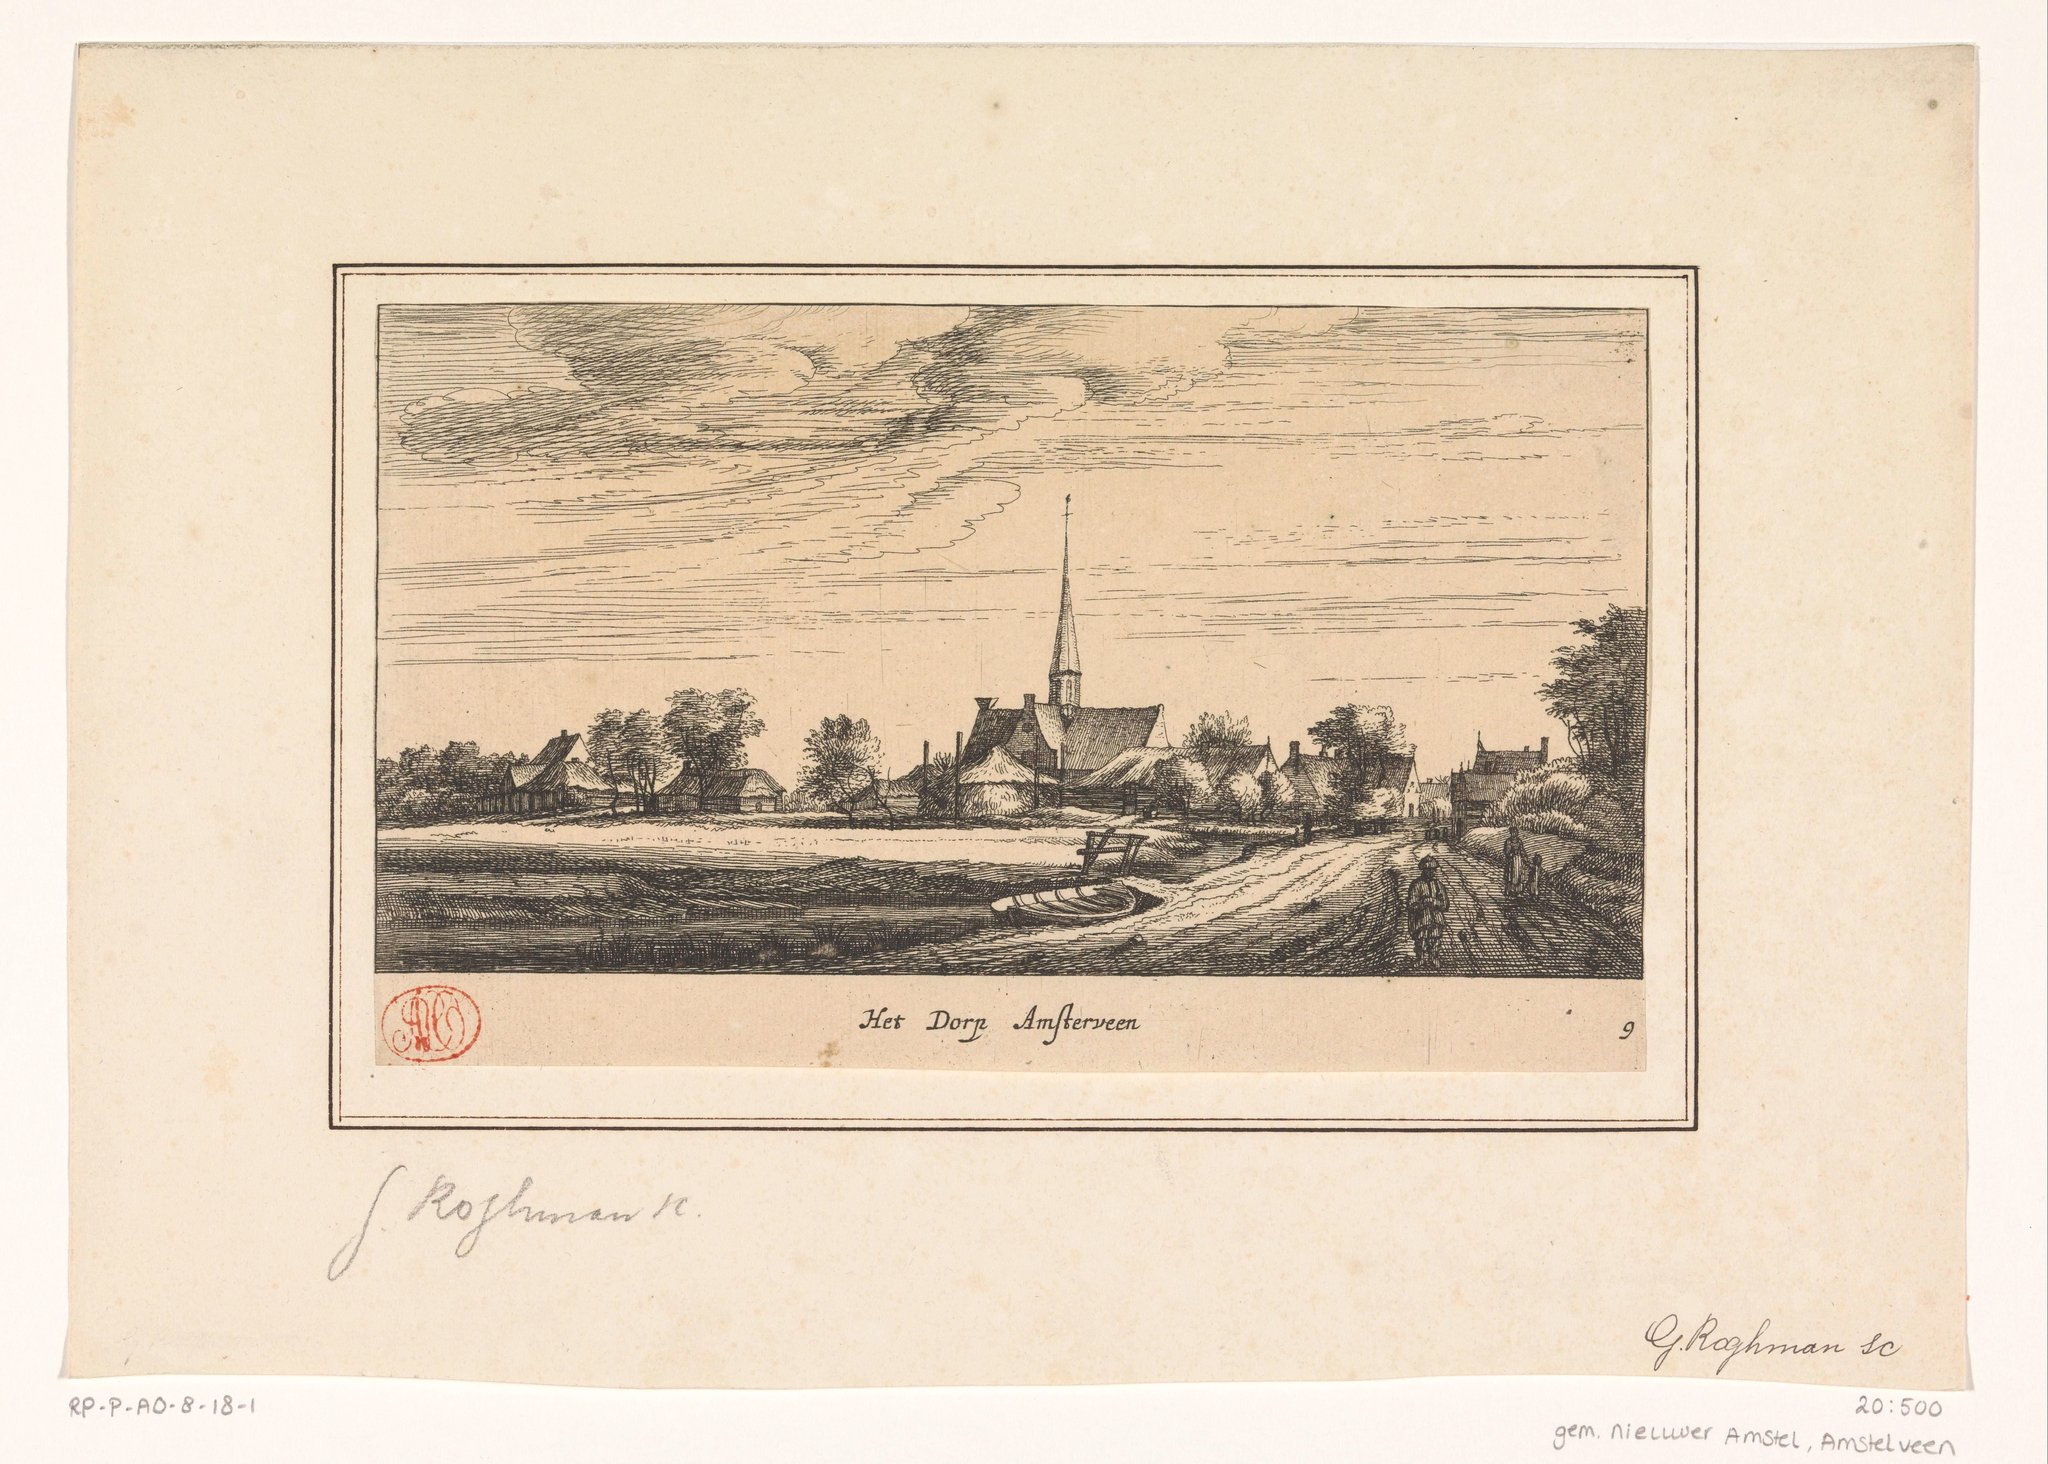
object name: print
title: Het dorp Amsterveen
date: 1637-1652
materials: paper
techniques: engraving, etching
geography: amsterdam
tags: prospect of village, silhouette of village, church (exterior)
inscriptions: collector's mark: Lugt 2233, collector's mark: Lugt 195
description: Deze prent is onderdeel van een serie van dertien landschappen met dorpen rondom Amsterdam, gemaakt door Geertruydt Roghman naar tekeningen van haar broer Roelant Roghman. Tekening door Roelant Roghman in collectie Teylers Museum te Haarlem.